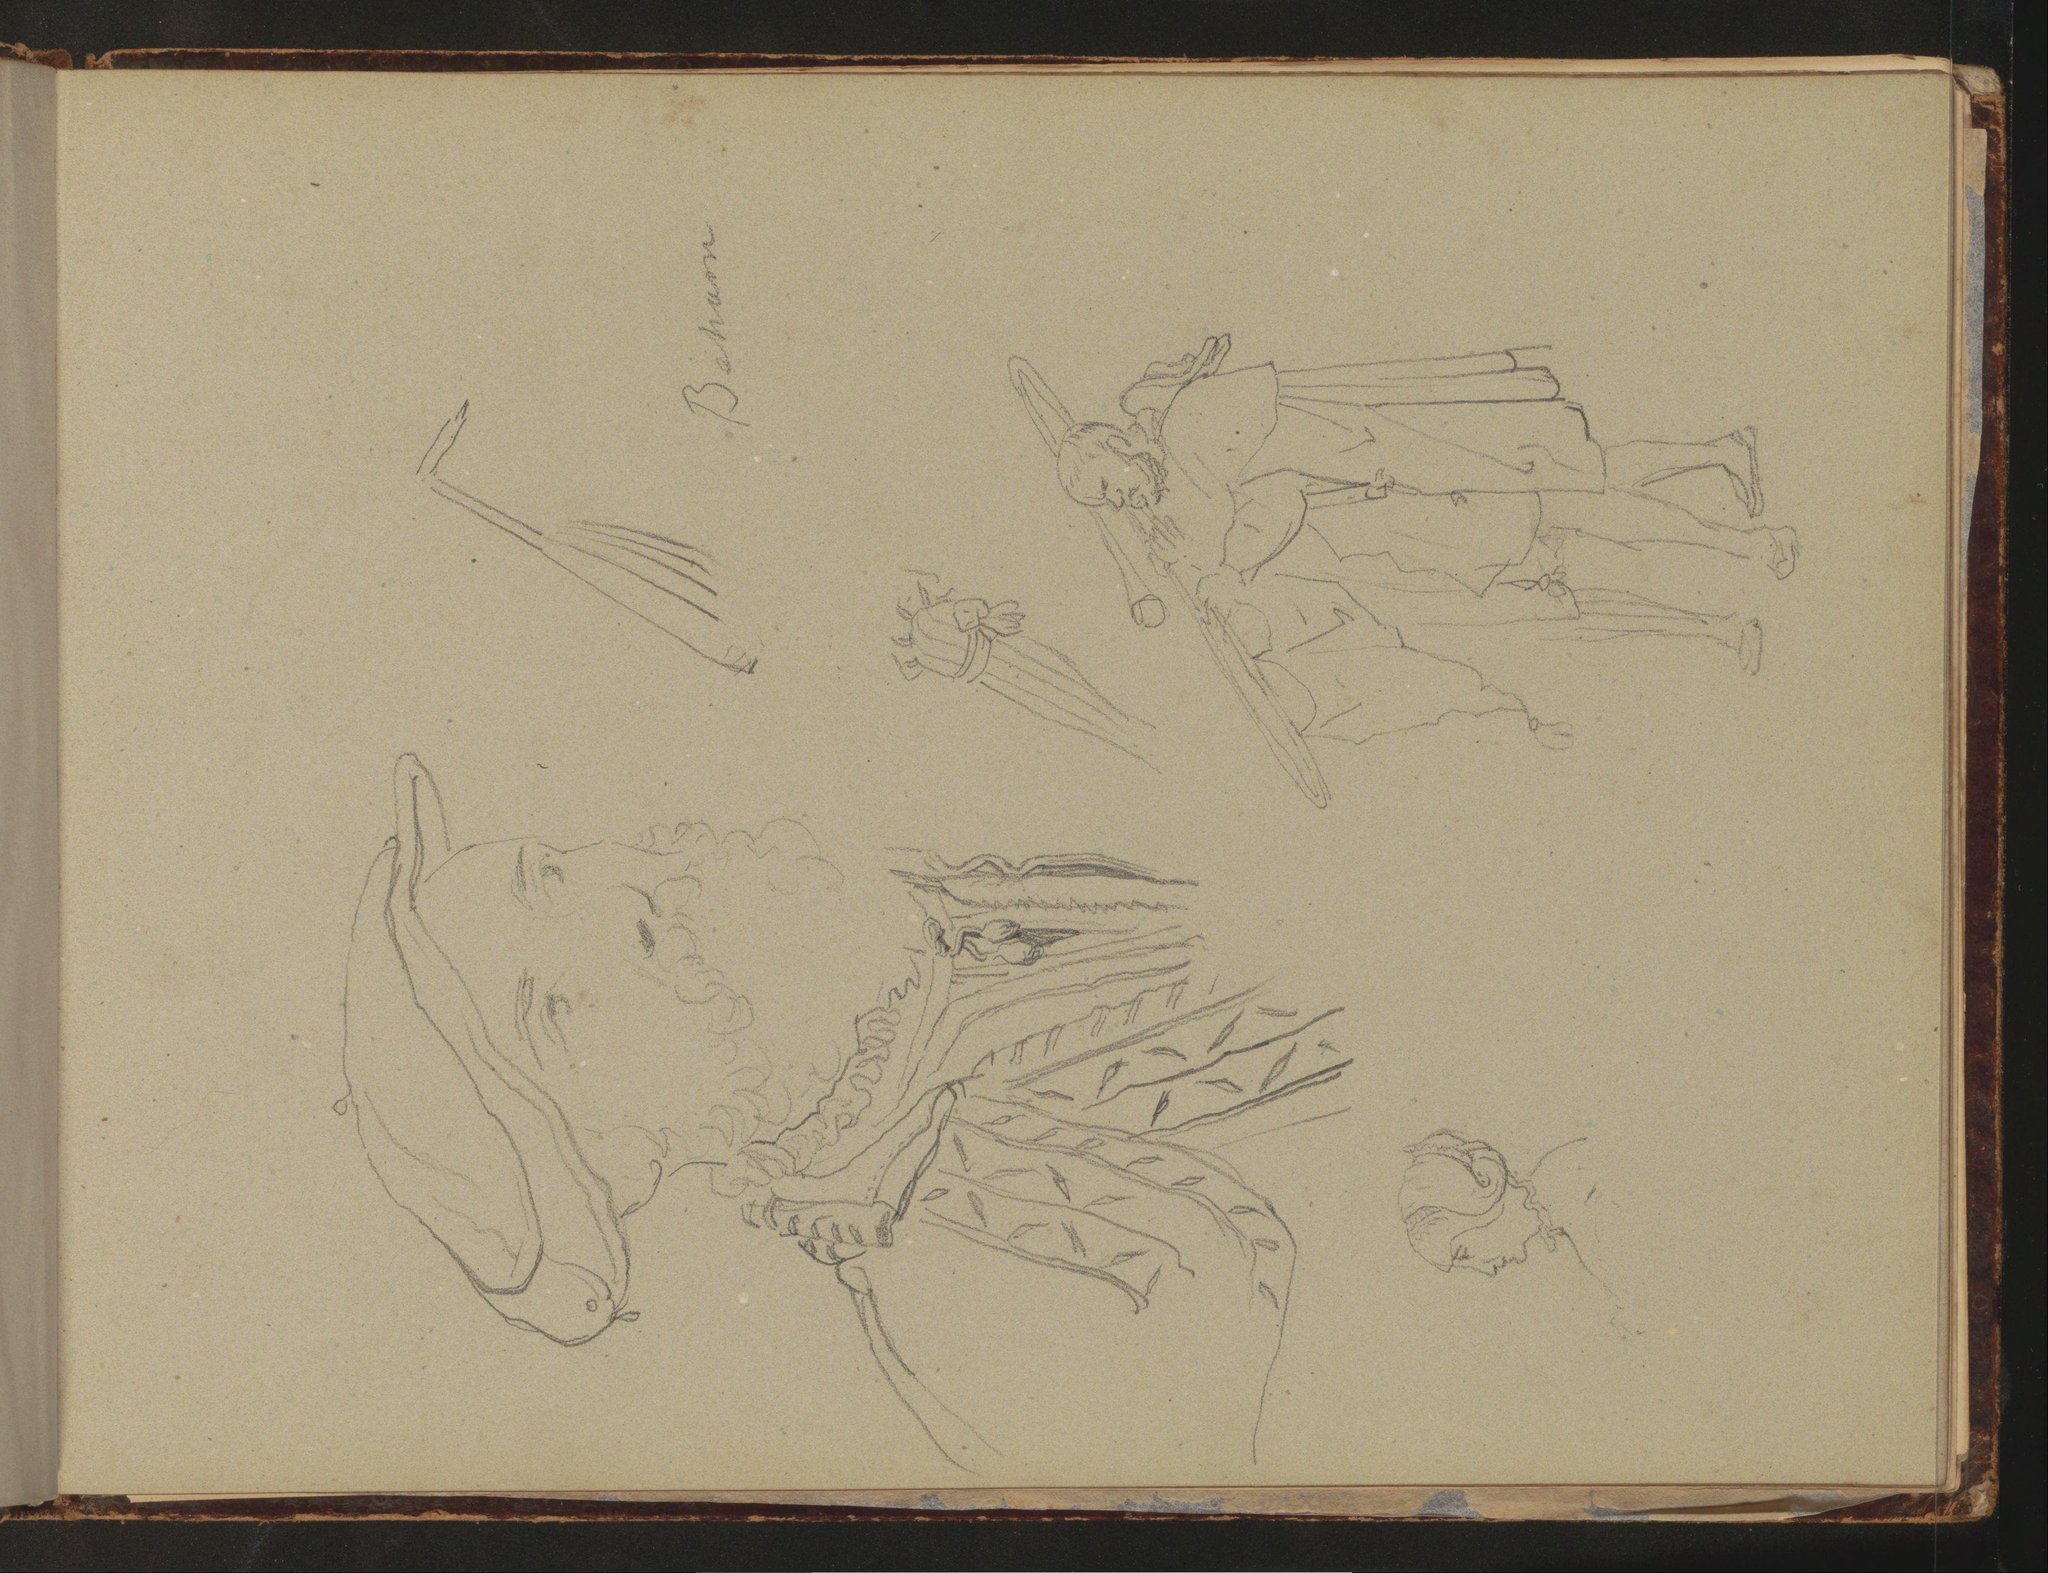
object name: sketchbook leaf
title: Trombonespeler, portretten en een luit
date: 1822-1880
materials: paper, pencil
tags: head (human), horn, trumpet, cornet, trombone, tuba (+ artist at work), lute, and special forms of lute, e.g.: theorbo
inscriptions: annotation: ‘Beham’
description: Blad 17 recto uit een schetsboek met 45 bladen.